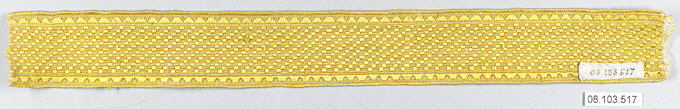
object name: galloon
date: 1801-1833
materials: cotton, silk